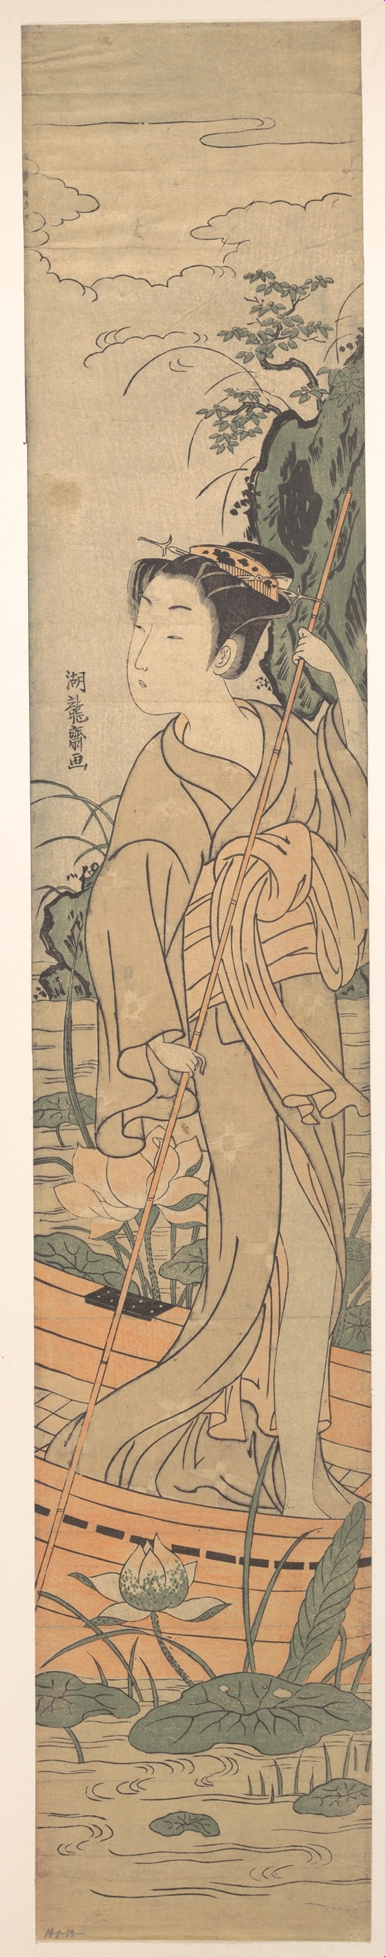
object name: print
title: Young Woman Poling Herself in a Boat among Pond Lilies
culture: japanese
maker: isoda koryūsai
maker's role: artist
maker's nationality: japanese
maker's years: 1735-1790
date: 1770-1790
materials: ink, paper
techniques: woodblock print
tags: women,lilies,boats